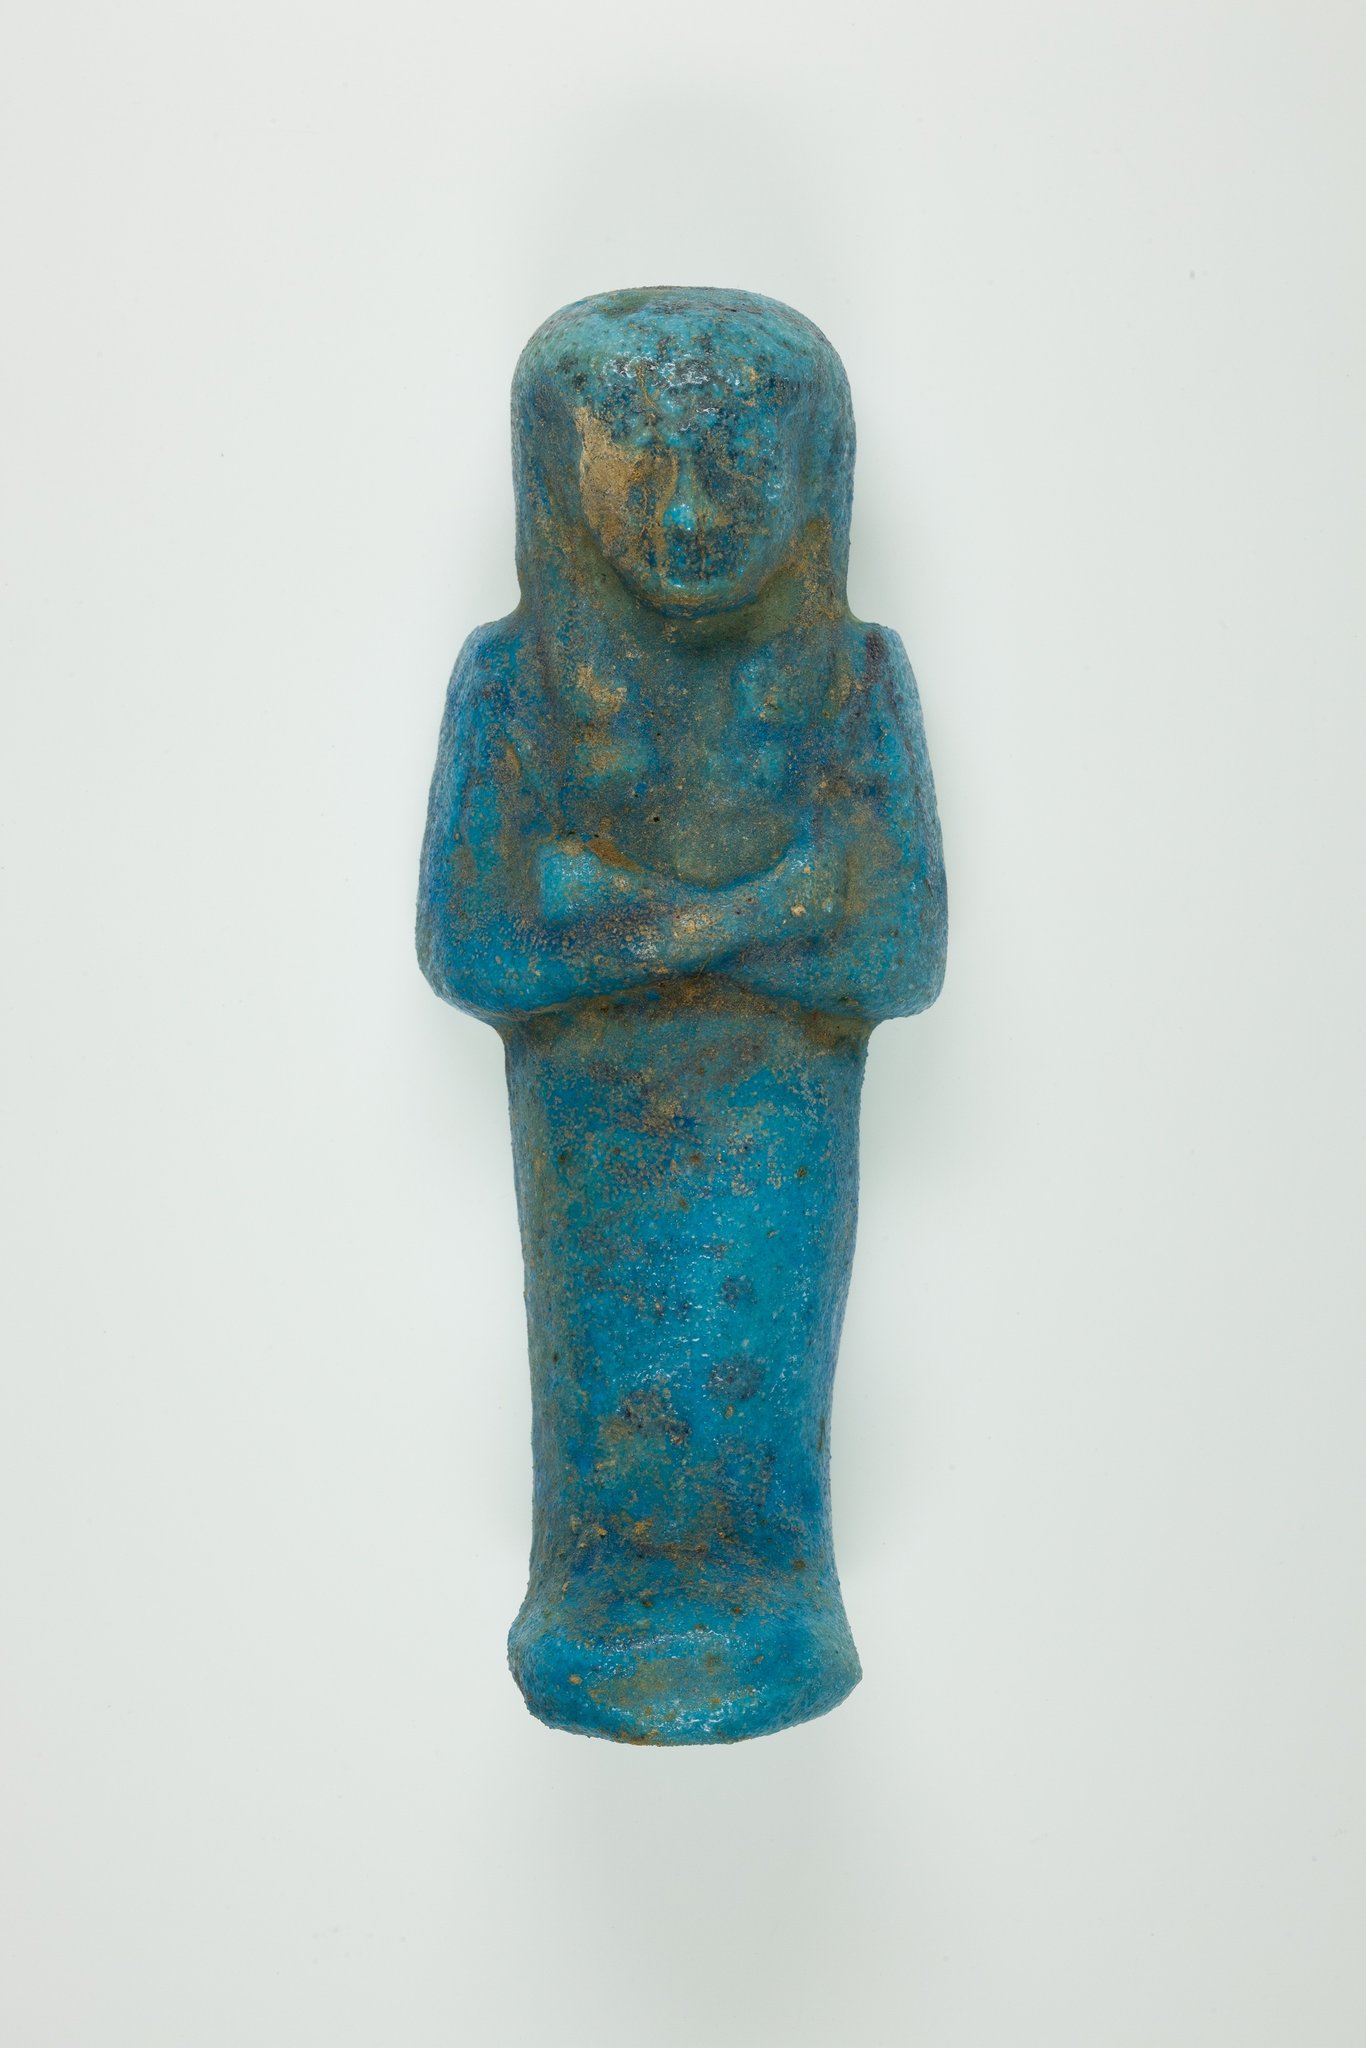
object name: worker shabti, henettawy c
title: Worker Shabti of Henettawy (C), Daughter of Isetemkheb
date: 990-970 BCE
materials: faience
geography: egypt